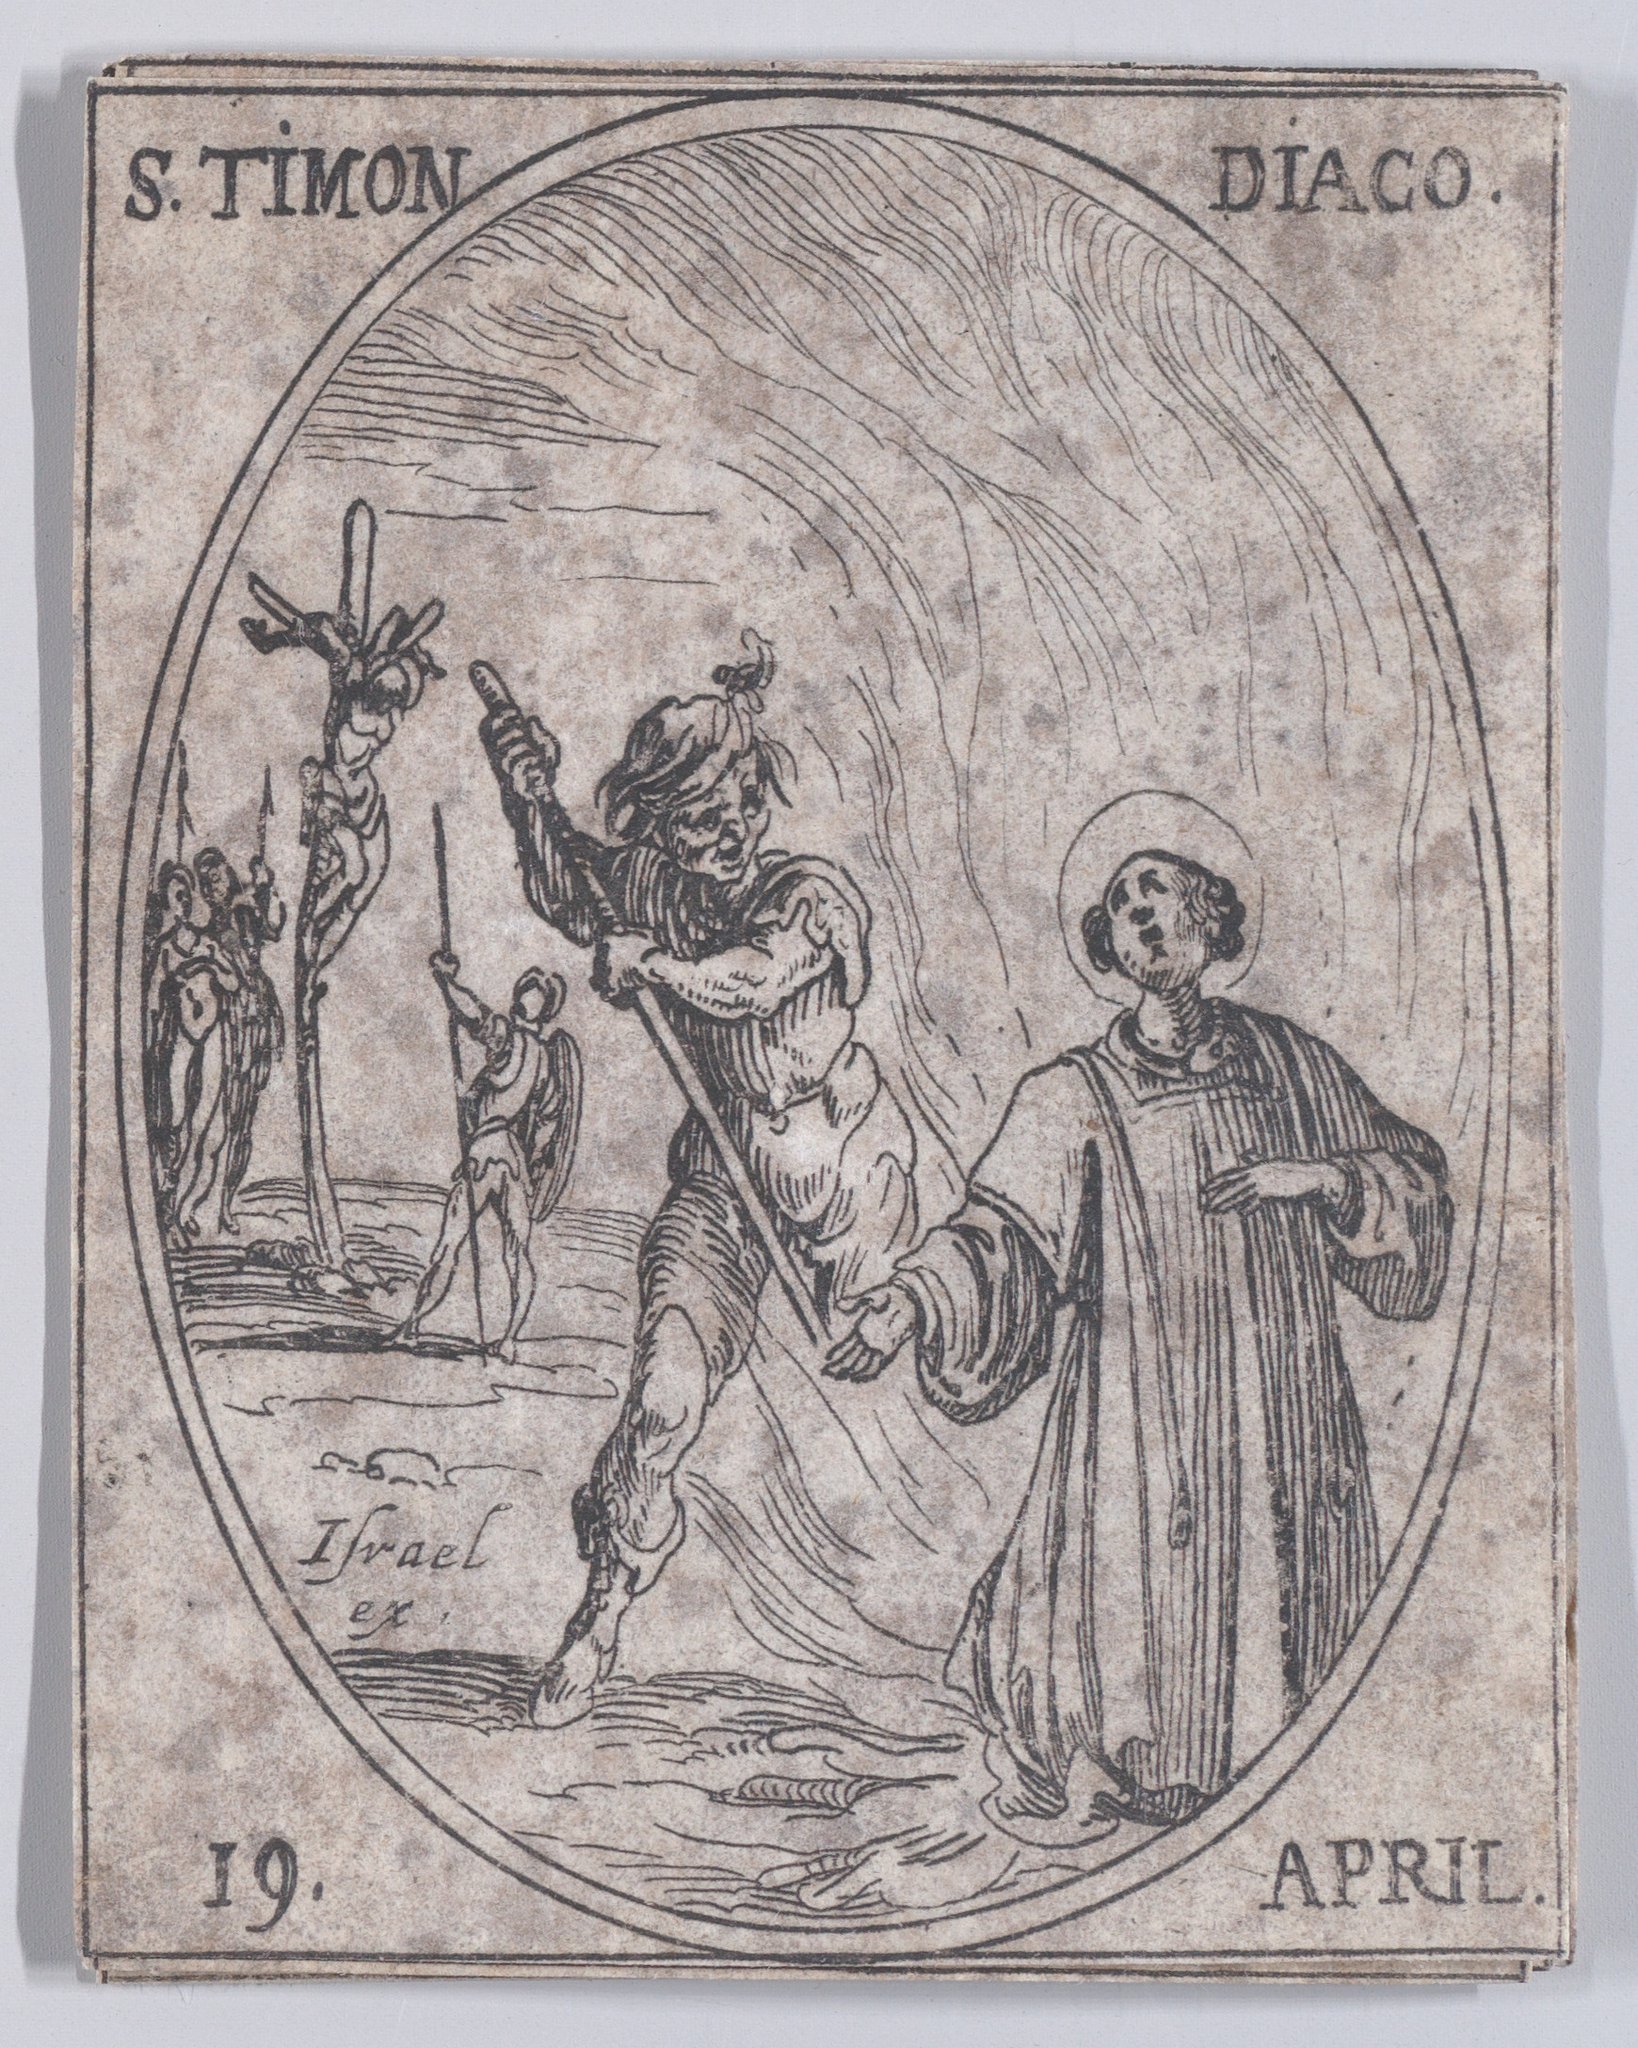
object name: print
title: S. Timon, diacre (St. Timon, Deacon), April 19th, from "Les Images De Tous Les Saincts et Saintes de L'Année" (Images of All of the Saints and Religious Events of the Year)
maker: jacques callot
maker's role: artist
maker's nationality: french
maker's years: 1592-1635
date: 1636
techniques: etching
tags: men,saints